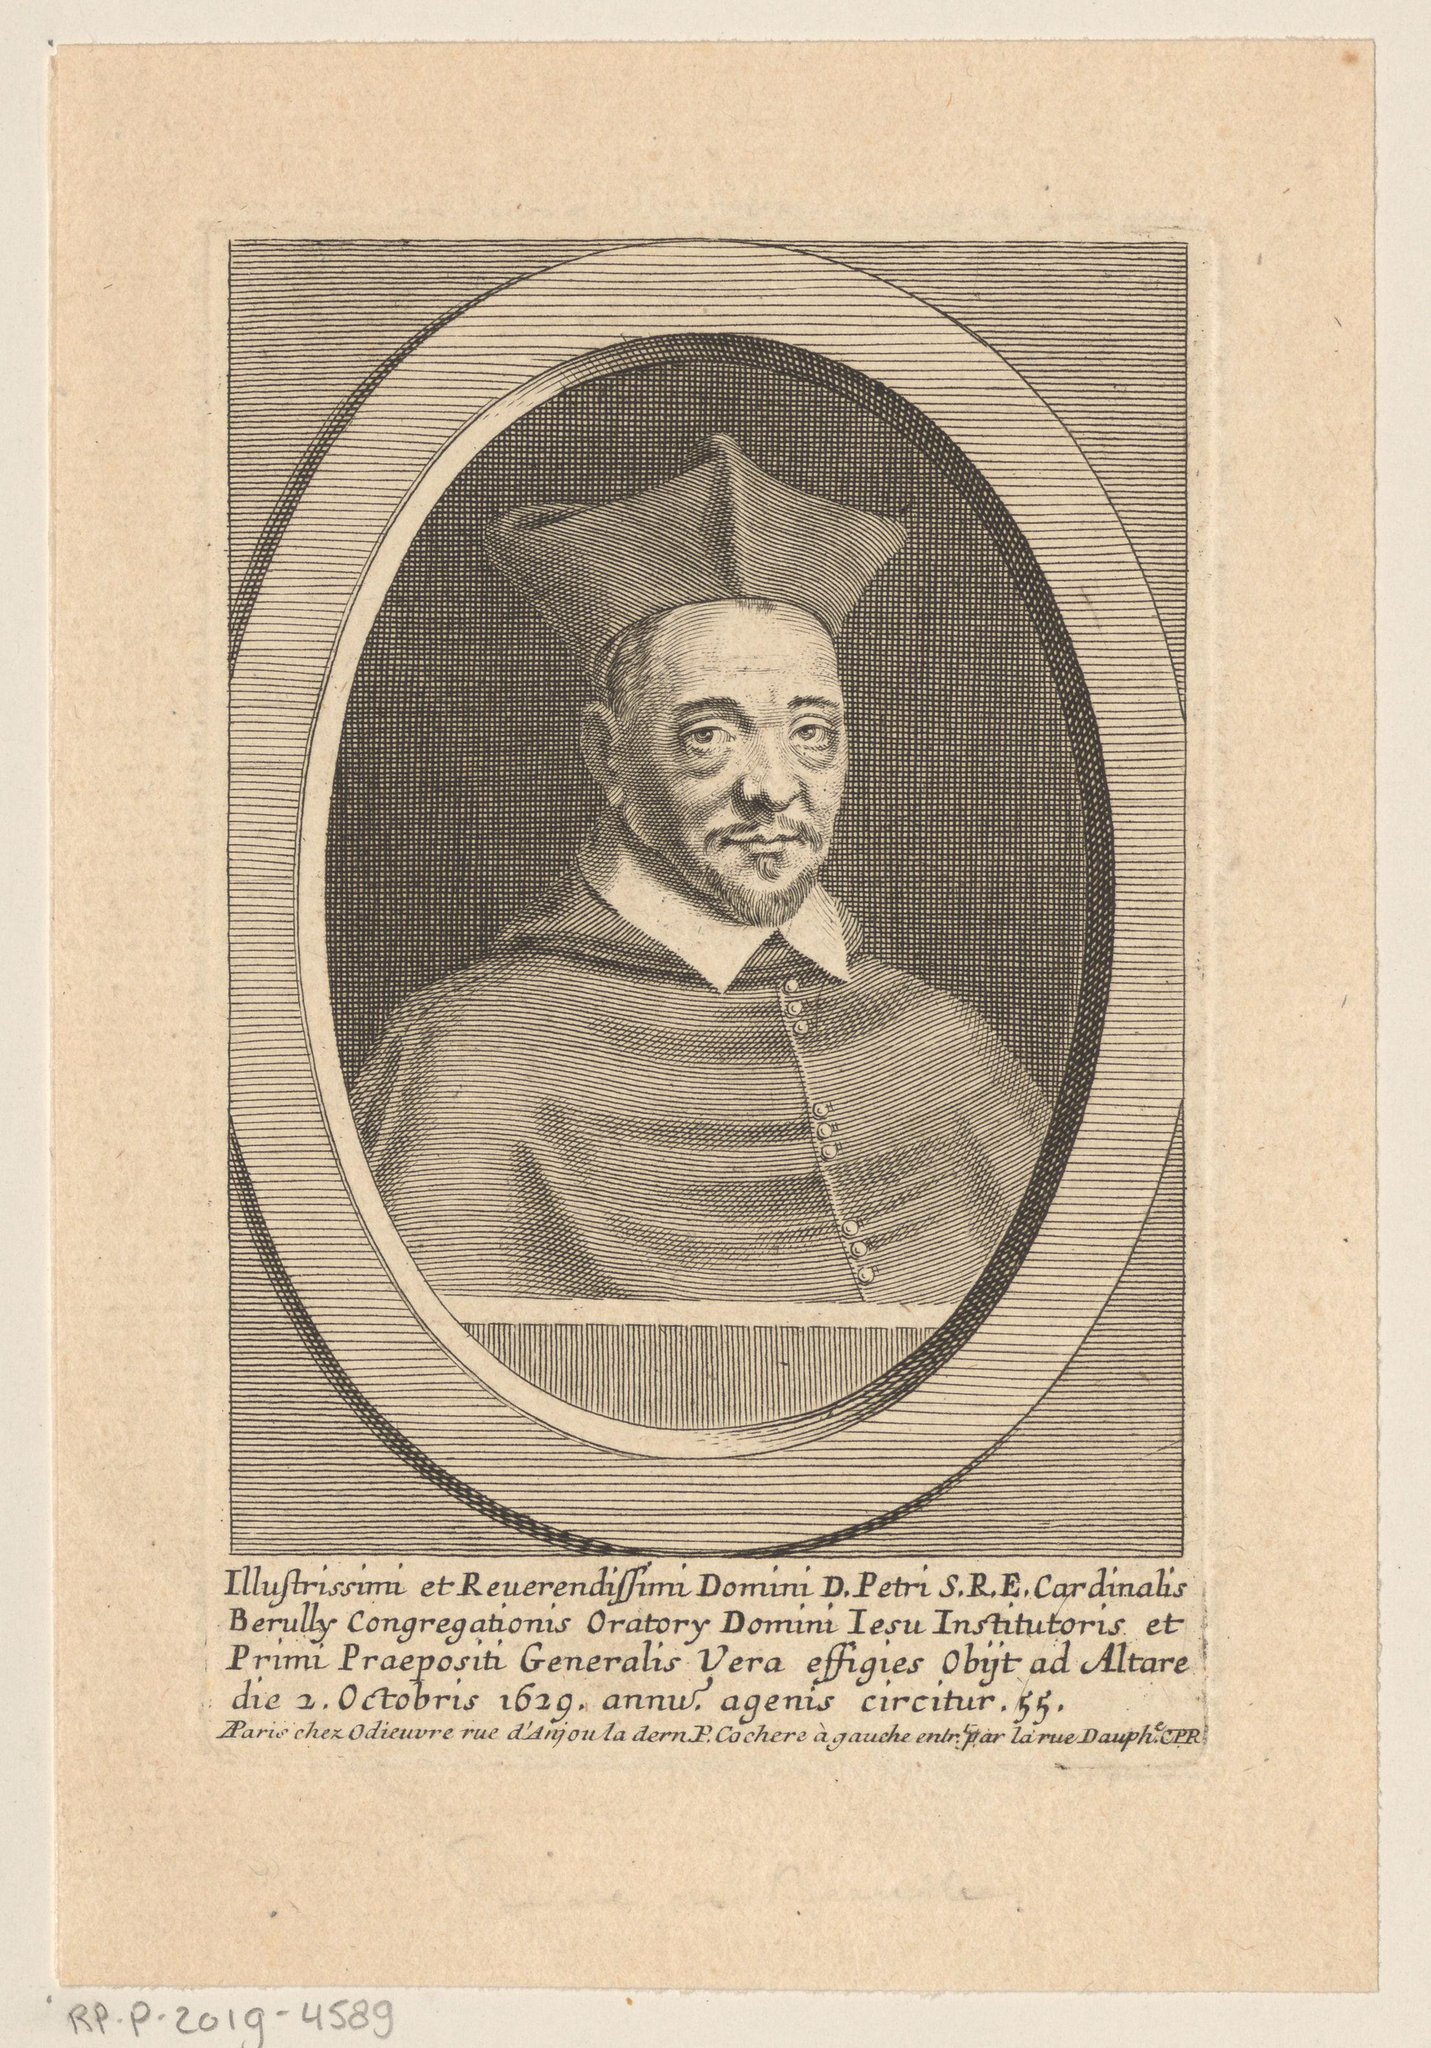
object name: print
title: Portret van Pierre de Bérulle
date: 1741-1747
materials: paper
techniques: engraving, etching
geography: france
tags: cardinal, historical persons